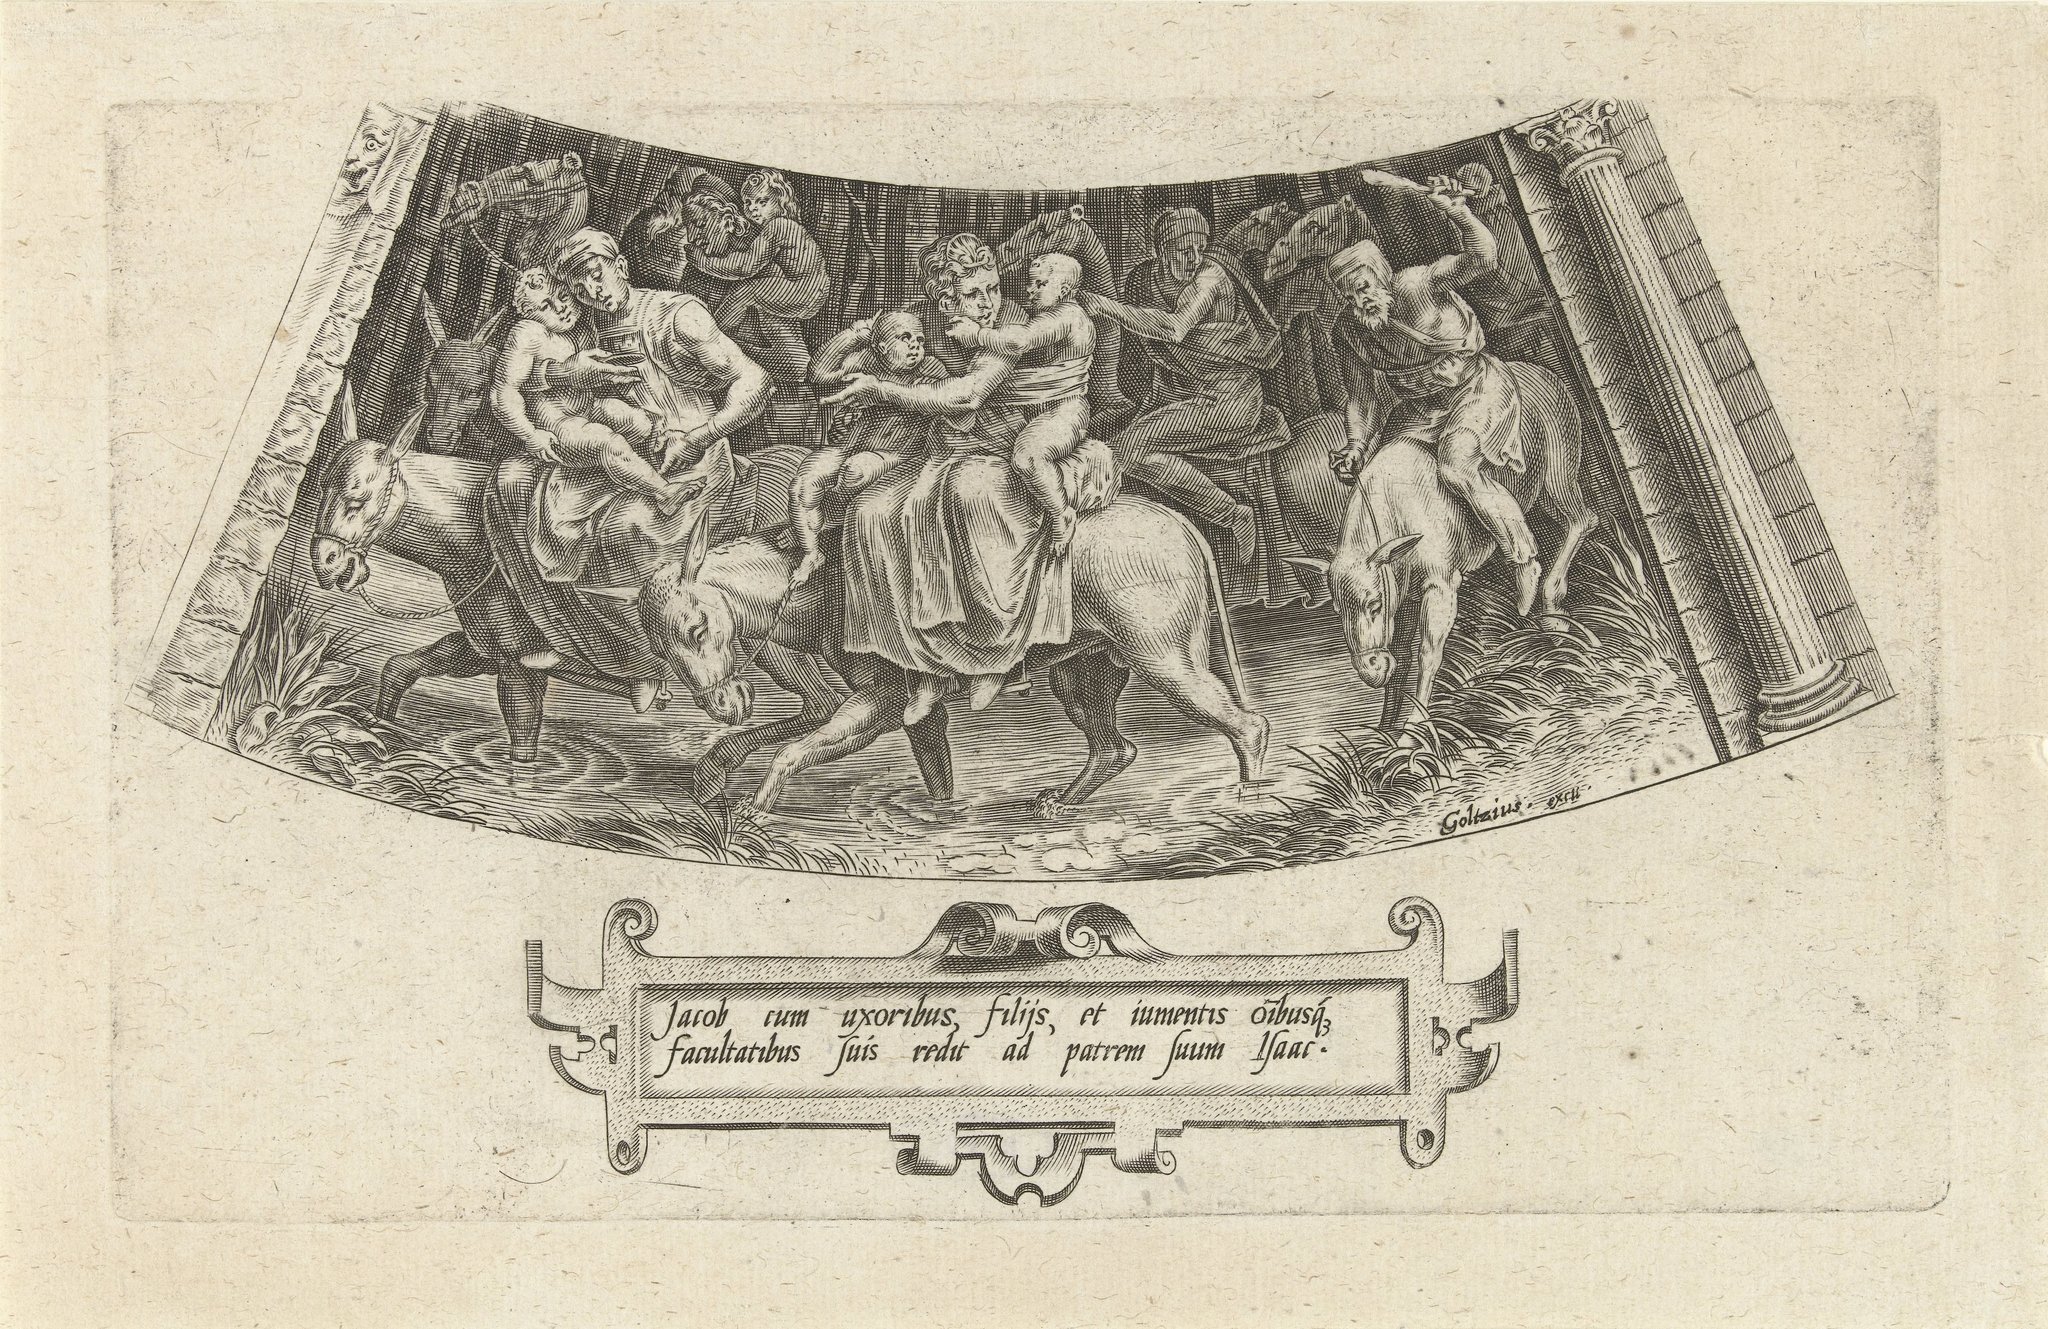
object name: print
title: De geschiedenis van Jacob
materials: paper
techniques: engraving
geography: antwerp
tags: ornament ~ cartouche, jacob's journey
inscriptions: caption: ‘Jacob cum uxoribus, filijs, et iumentis o[p]ibusque / facultatibus suis redit ad patrem suum Isaac.’, collector's mark: Lugt 2228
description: Ornament voor schotelrand. Jakob en zijn familie rijdend op ezels, terugkerend naar Kanaän. Met tekst in Latijn in cartouche onder de voorstelling.